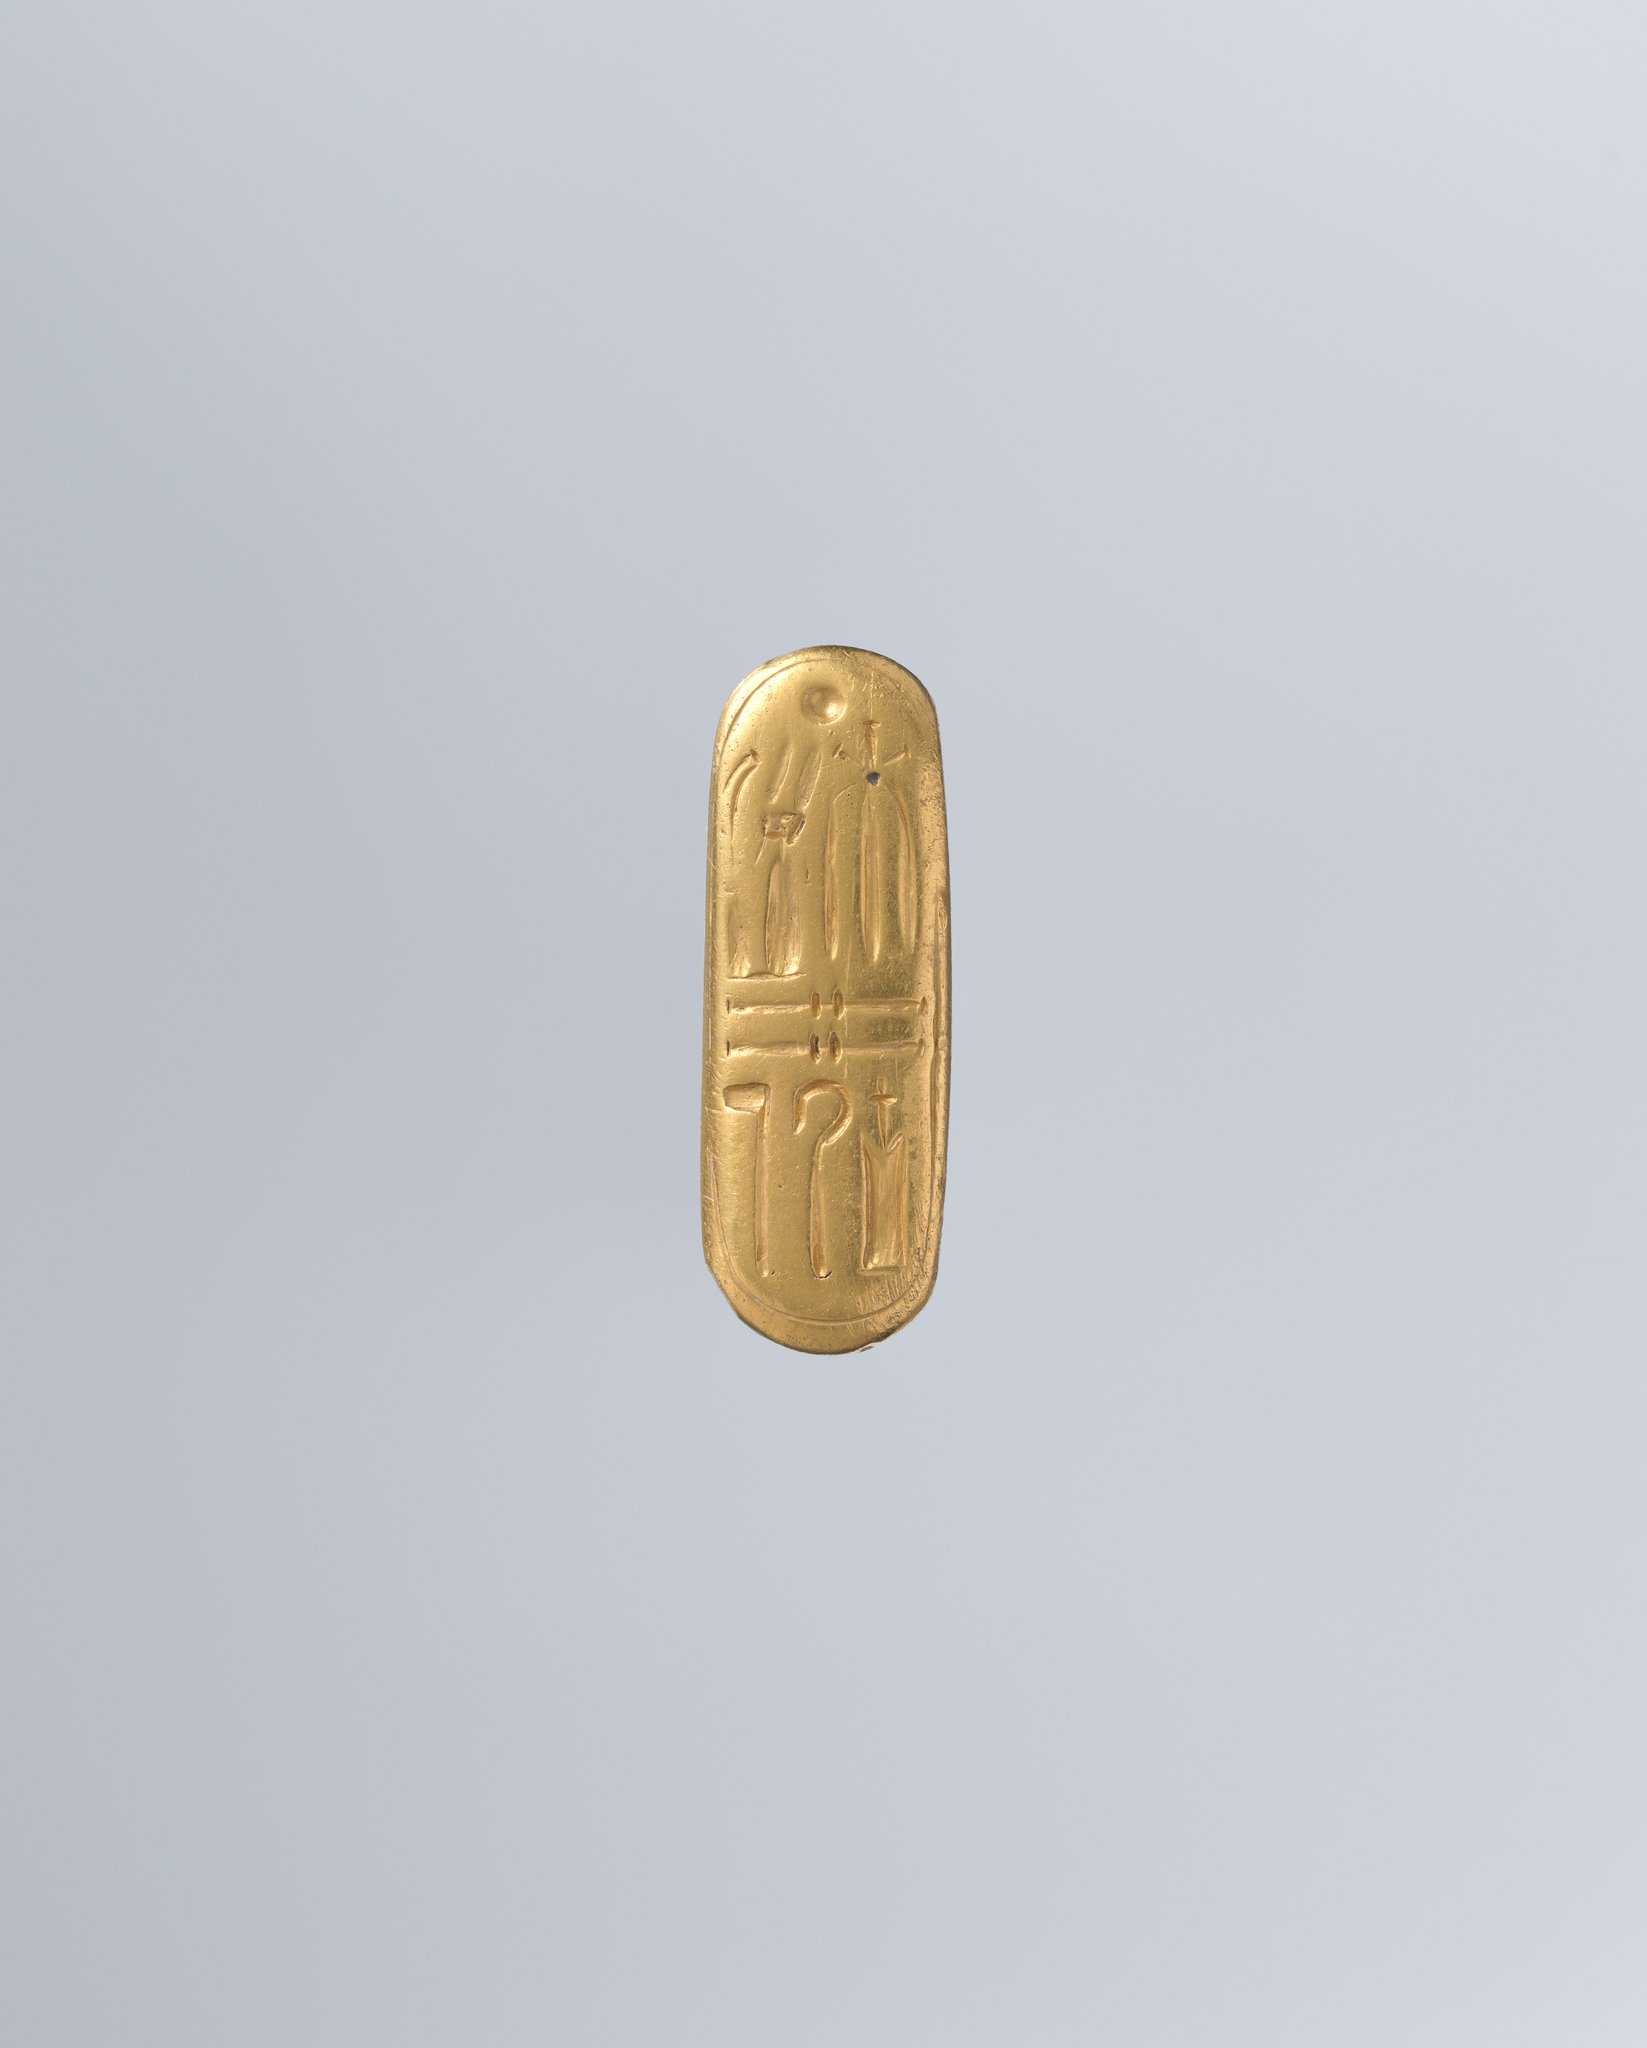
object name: ring, ramesses vi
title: Signet ring of Ramesses VI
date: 1143-1136 BCE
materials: gold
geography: egypt